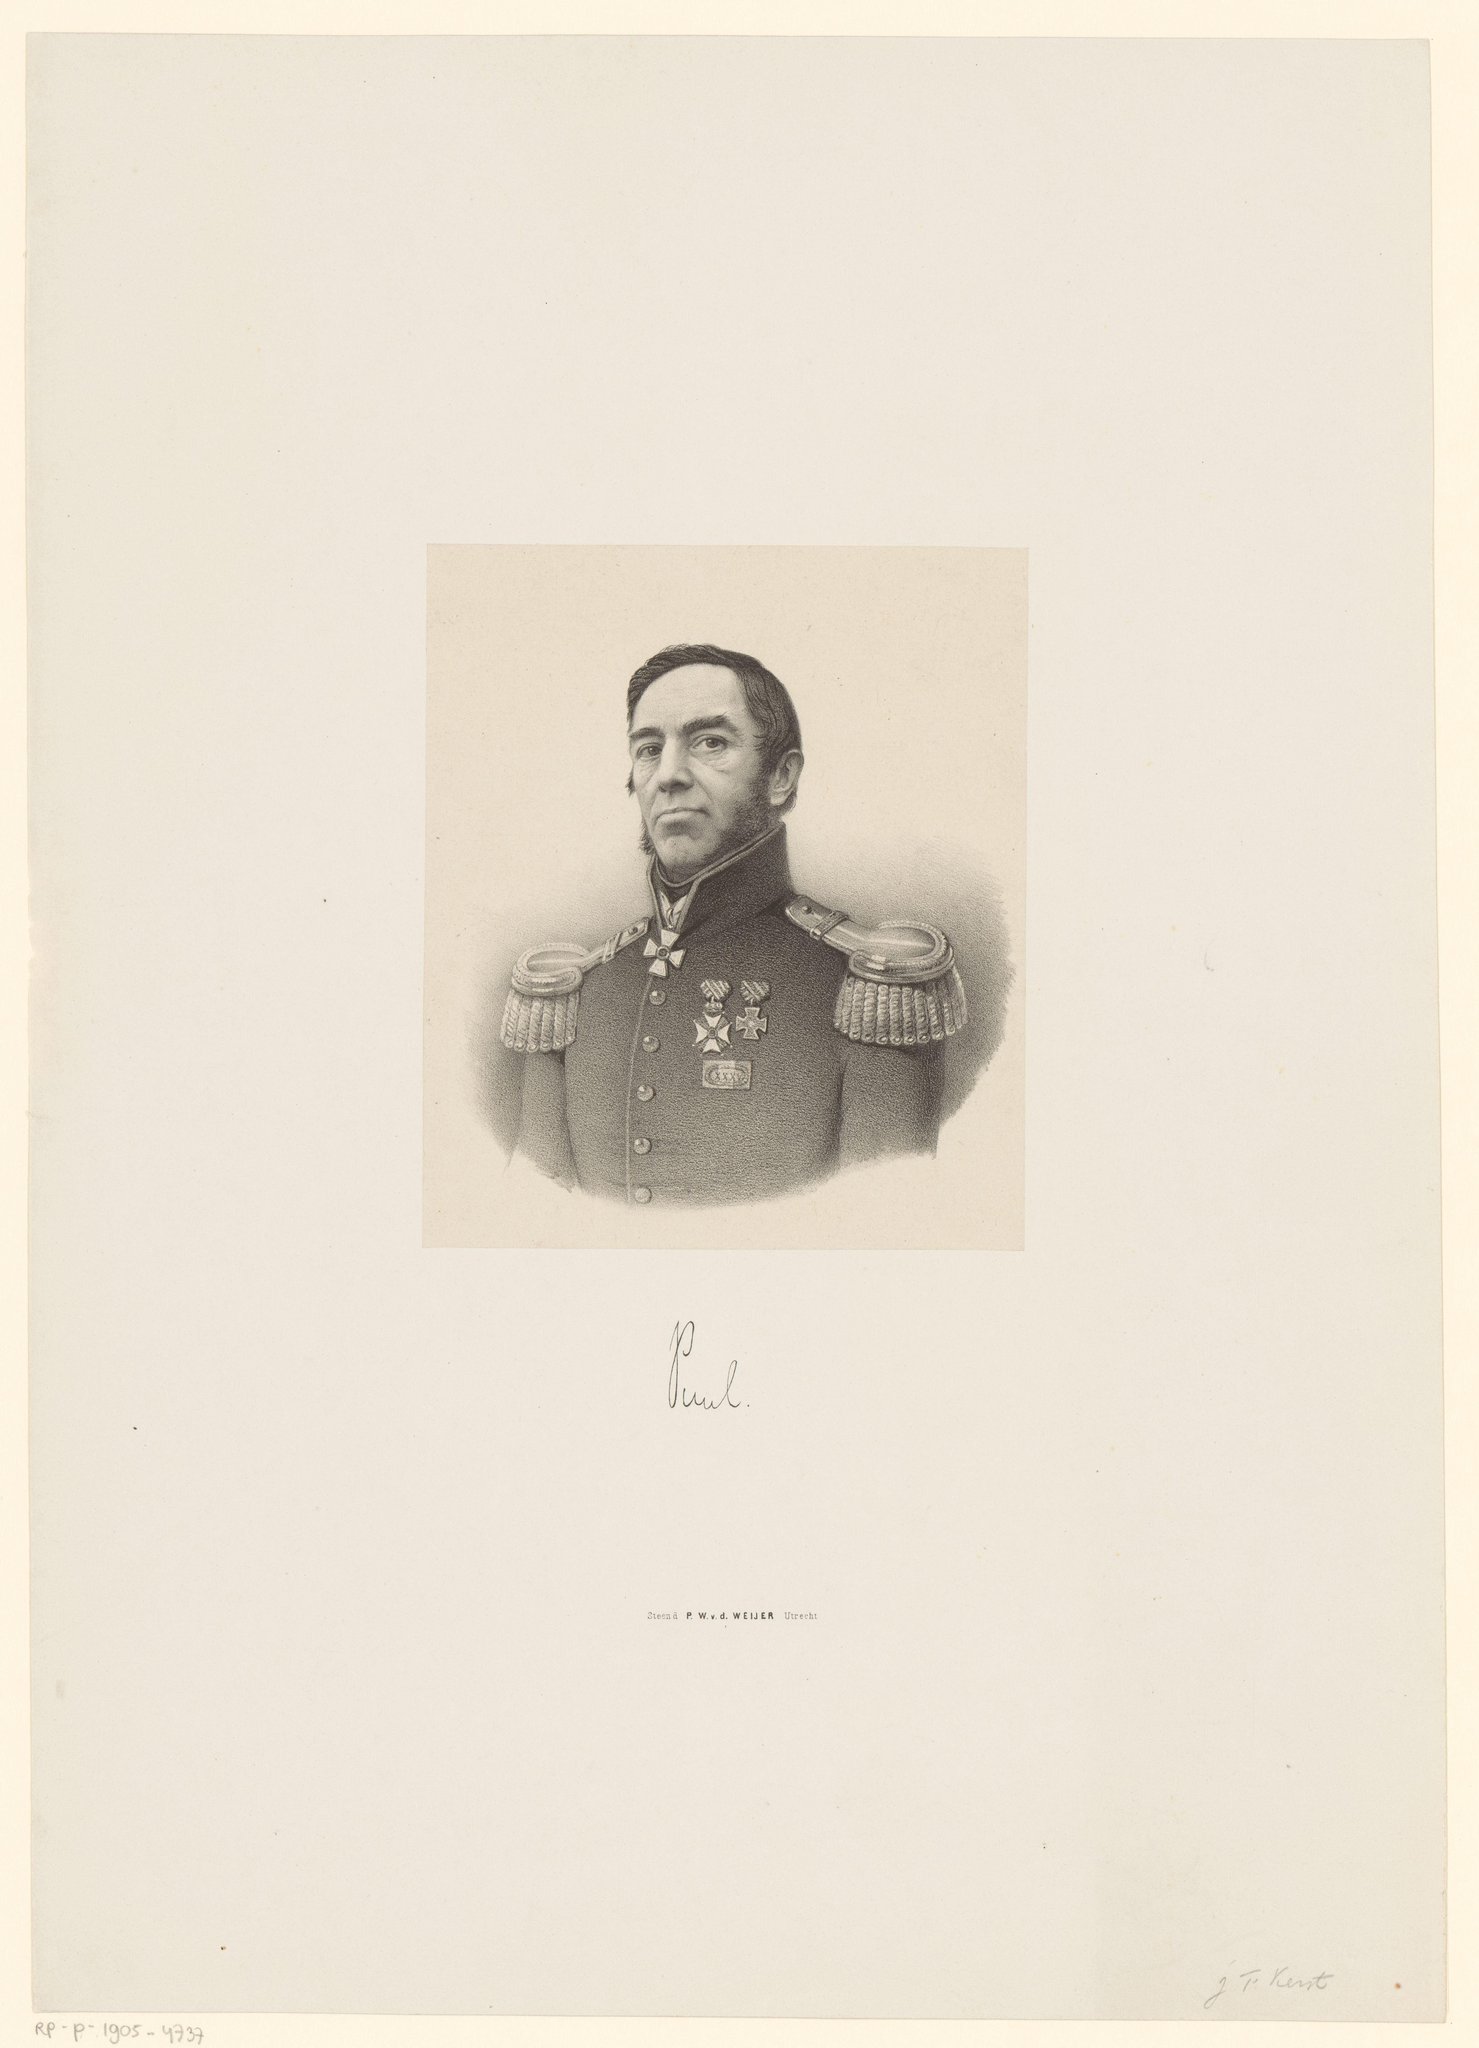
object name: print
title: Portret van Johannes Fredericus Kerst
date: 1842-1880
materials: paper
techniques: lithograph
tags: knighthood order, historical persons (+ (full) bust portrait)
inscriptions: collector's mark: Lugt 2228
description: De geportretteerde draagt drie ridderorden en een onderscheiding voor 35 jaren in dienst. Onder het portret zijn signatuur.